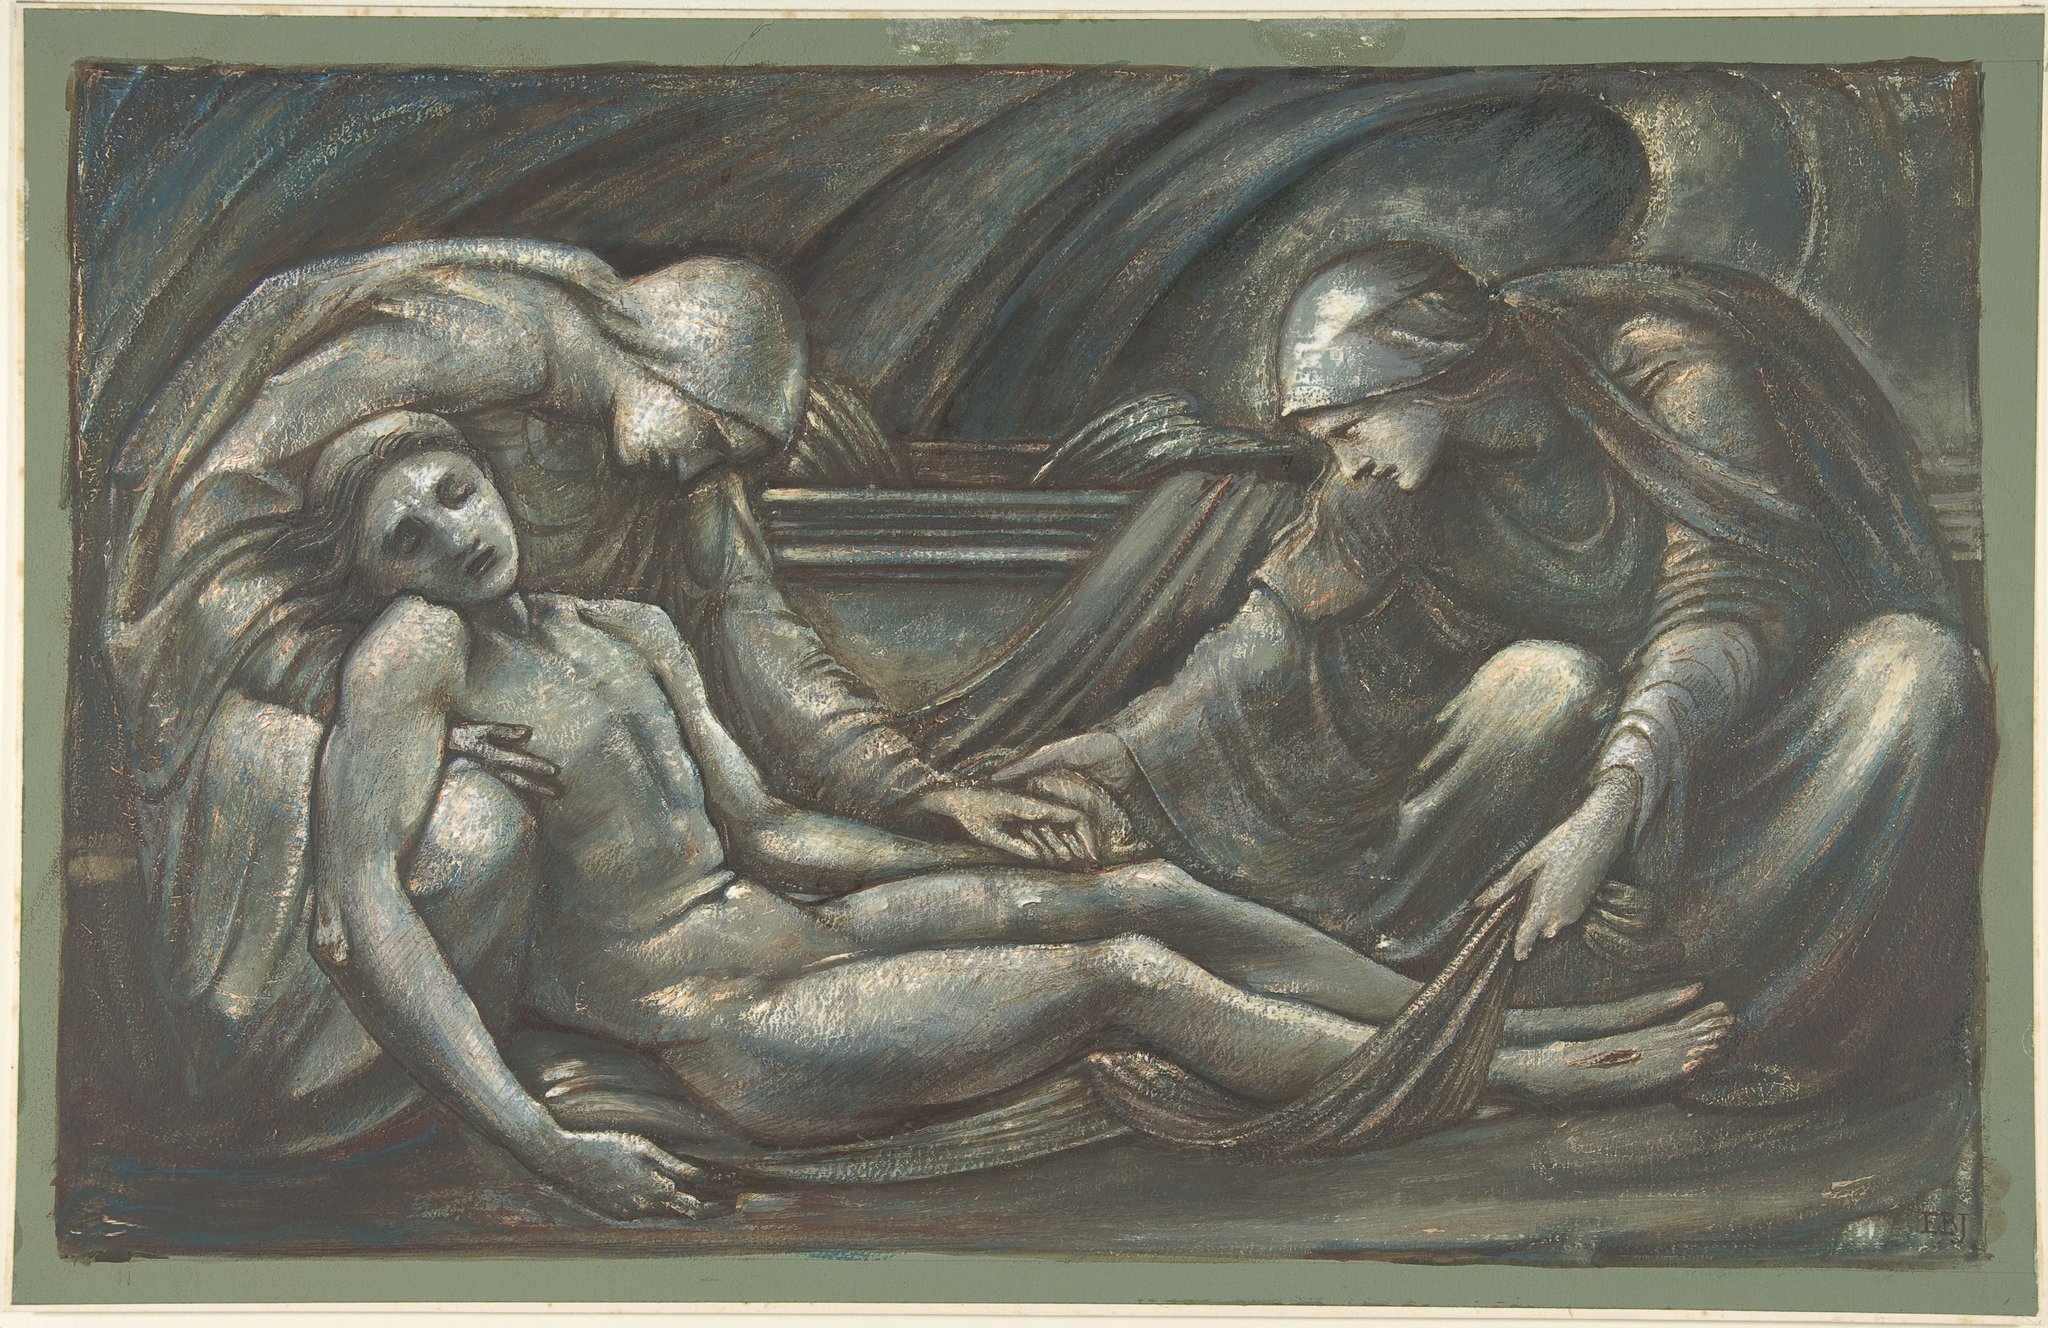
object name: drawing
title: The Entombment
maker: sir edward burne-jones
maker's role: artist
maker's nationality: british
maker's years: 1833-1898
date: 1879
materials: paint, gouache, paper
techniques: heightening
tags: sadness,women,christ,entombment